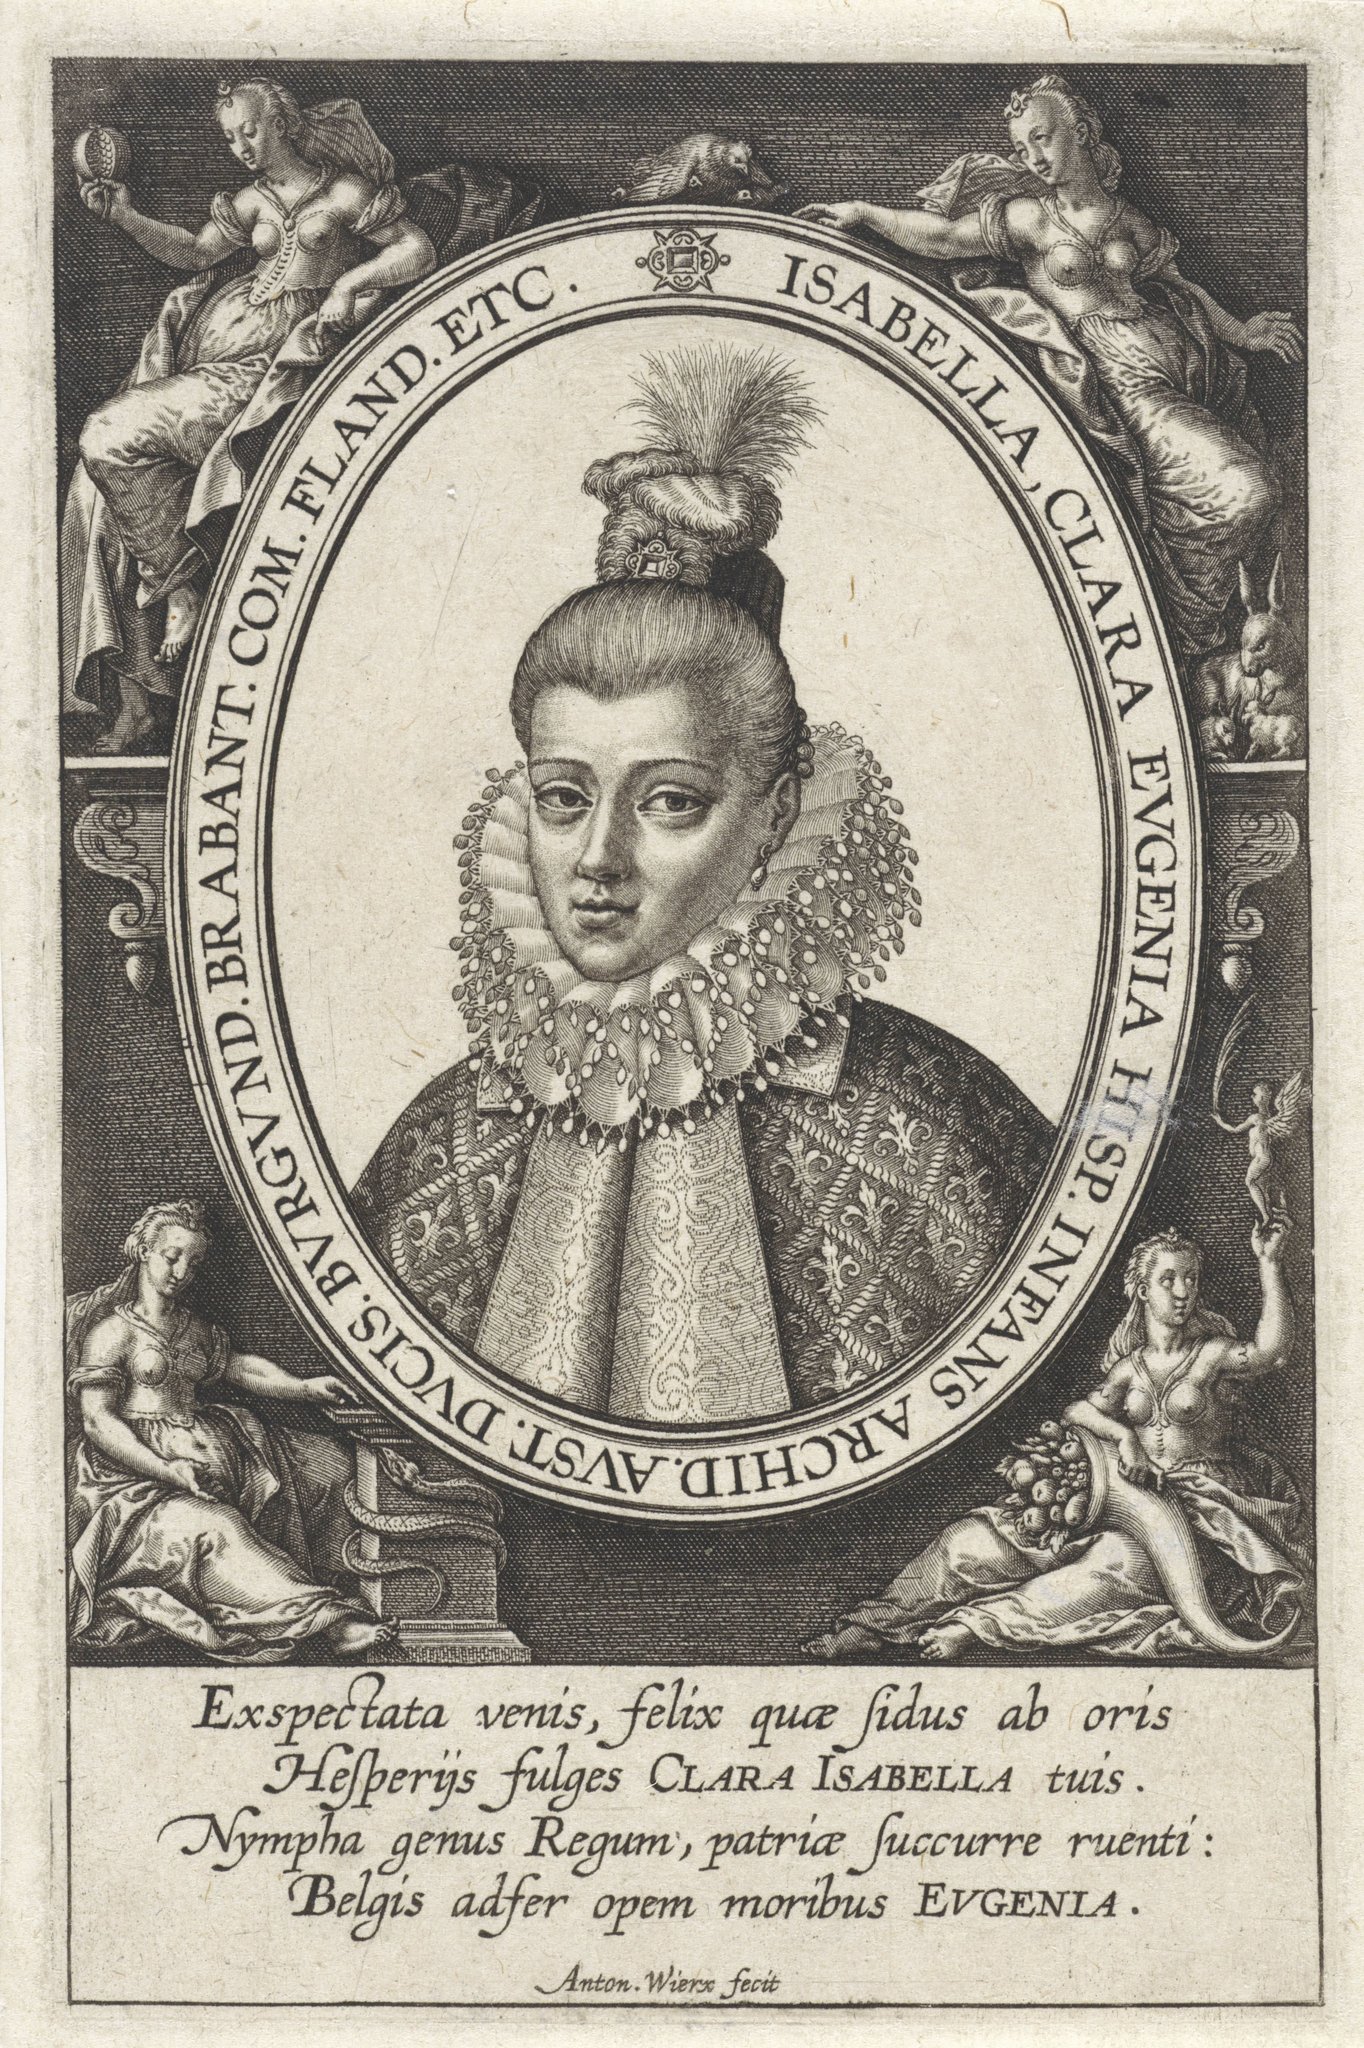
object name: print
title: Portret van Isabella Clara Eugenia, infante van Spanje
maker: antonie wierix (ii)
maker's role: draughtsman, print maker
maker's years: 1555-1604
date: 1598-1604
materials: paper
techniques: engraving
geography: antwerp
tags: infante van spanje isabella clara eugenia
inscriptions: collector's mark: Lugt 2228, number: ‘22. - 31,a.’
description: Busteportret van Isabella Clara Eugenia, infante van Spanje Albrecht en gemalin van aartshertog van Oostenrijk. In de hoeken allegorische vrouwfiguren. In de marge een vierregelig onderschrift in het Latijn.